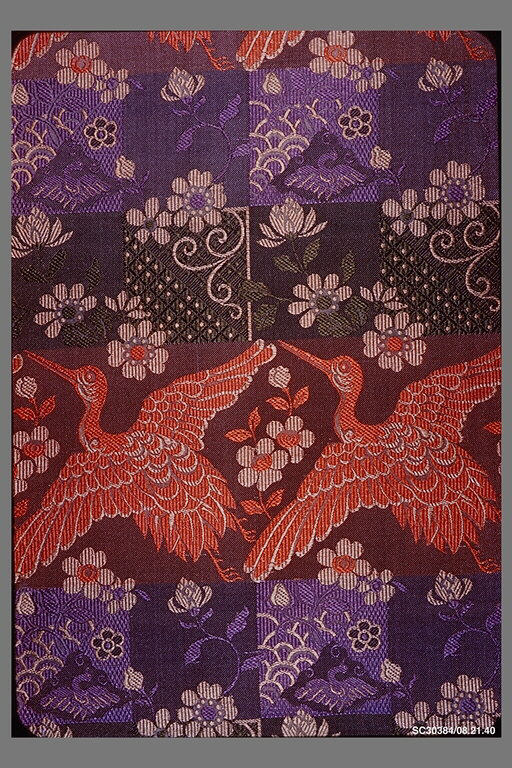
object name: textile sample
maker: Anonymous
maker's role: designer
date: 1900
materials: silk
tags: birds,flowers